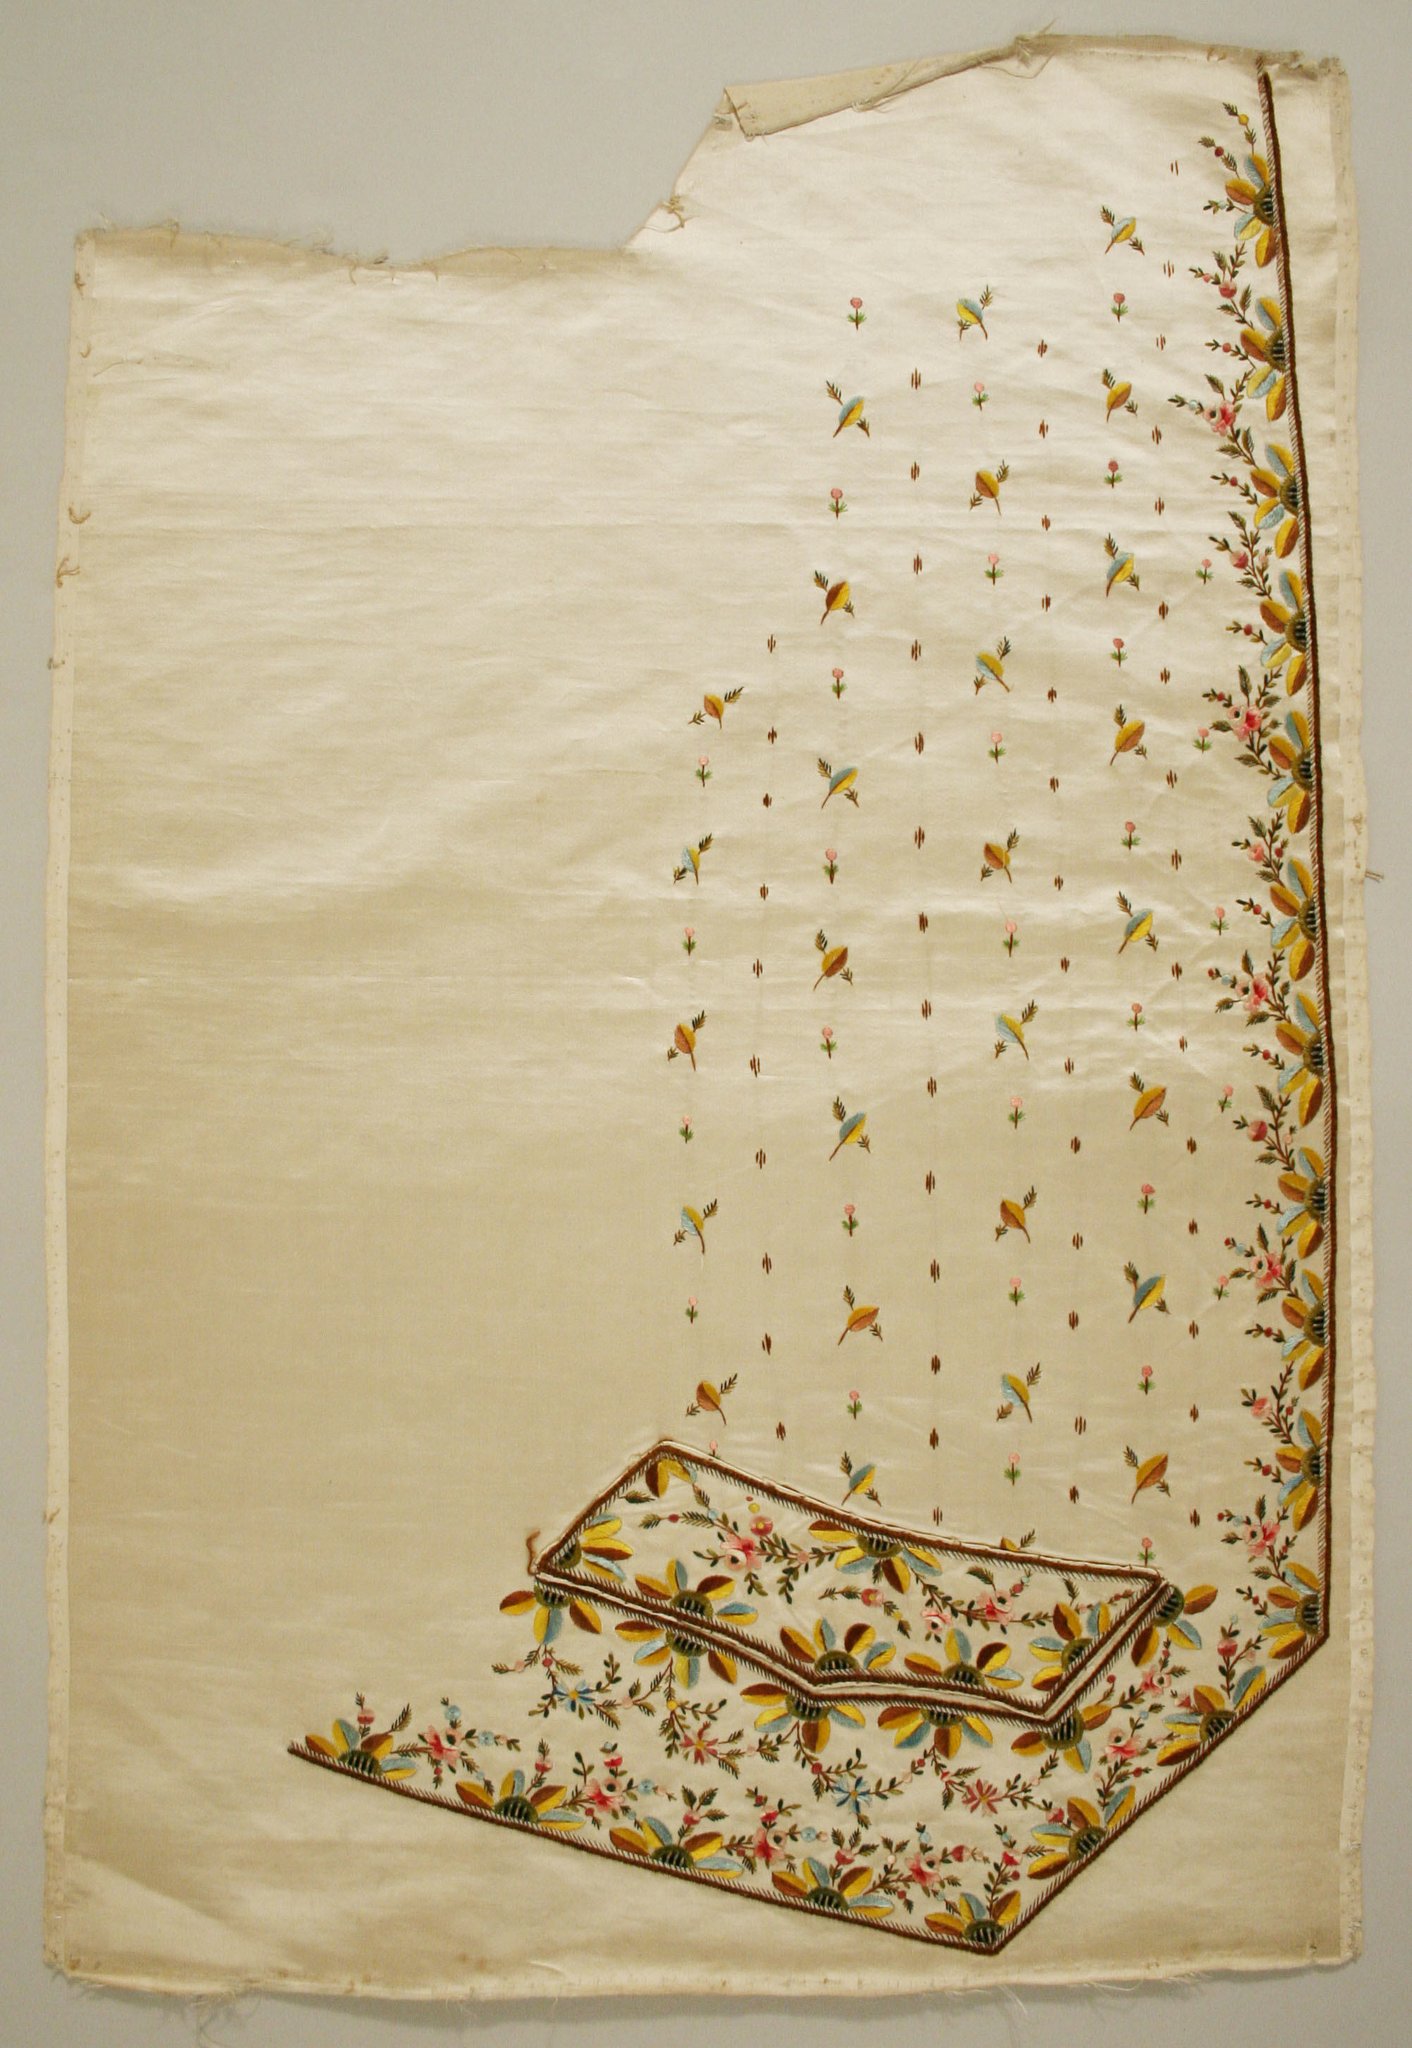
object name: waistcoat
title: Waistcoat panels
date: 1780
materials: silk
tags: flowers